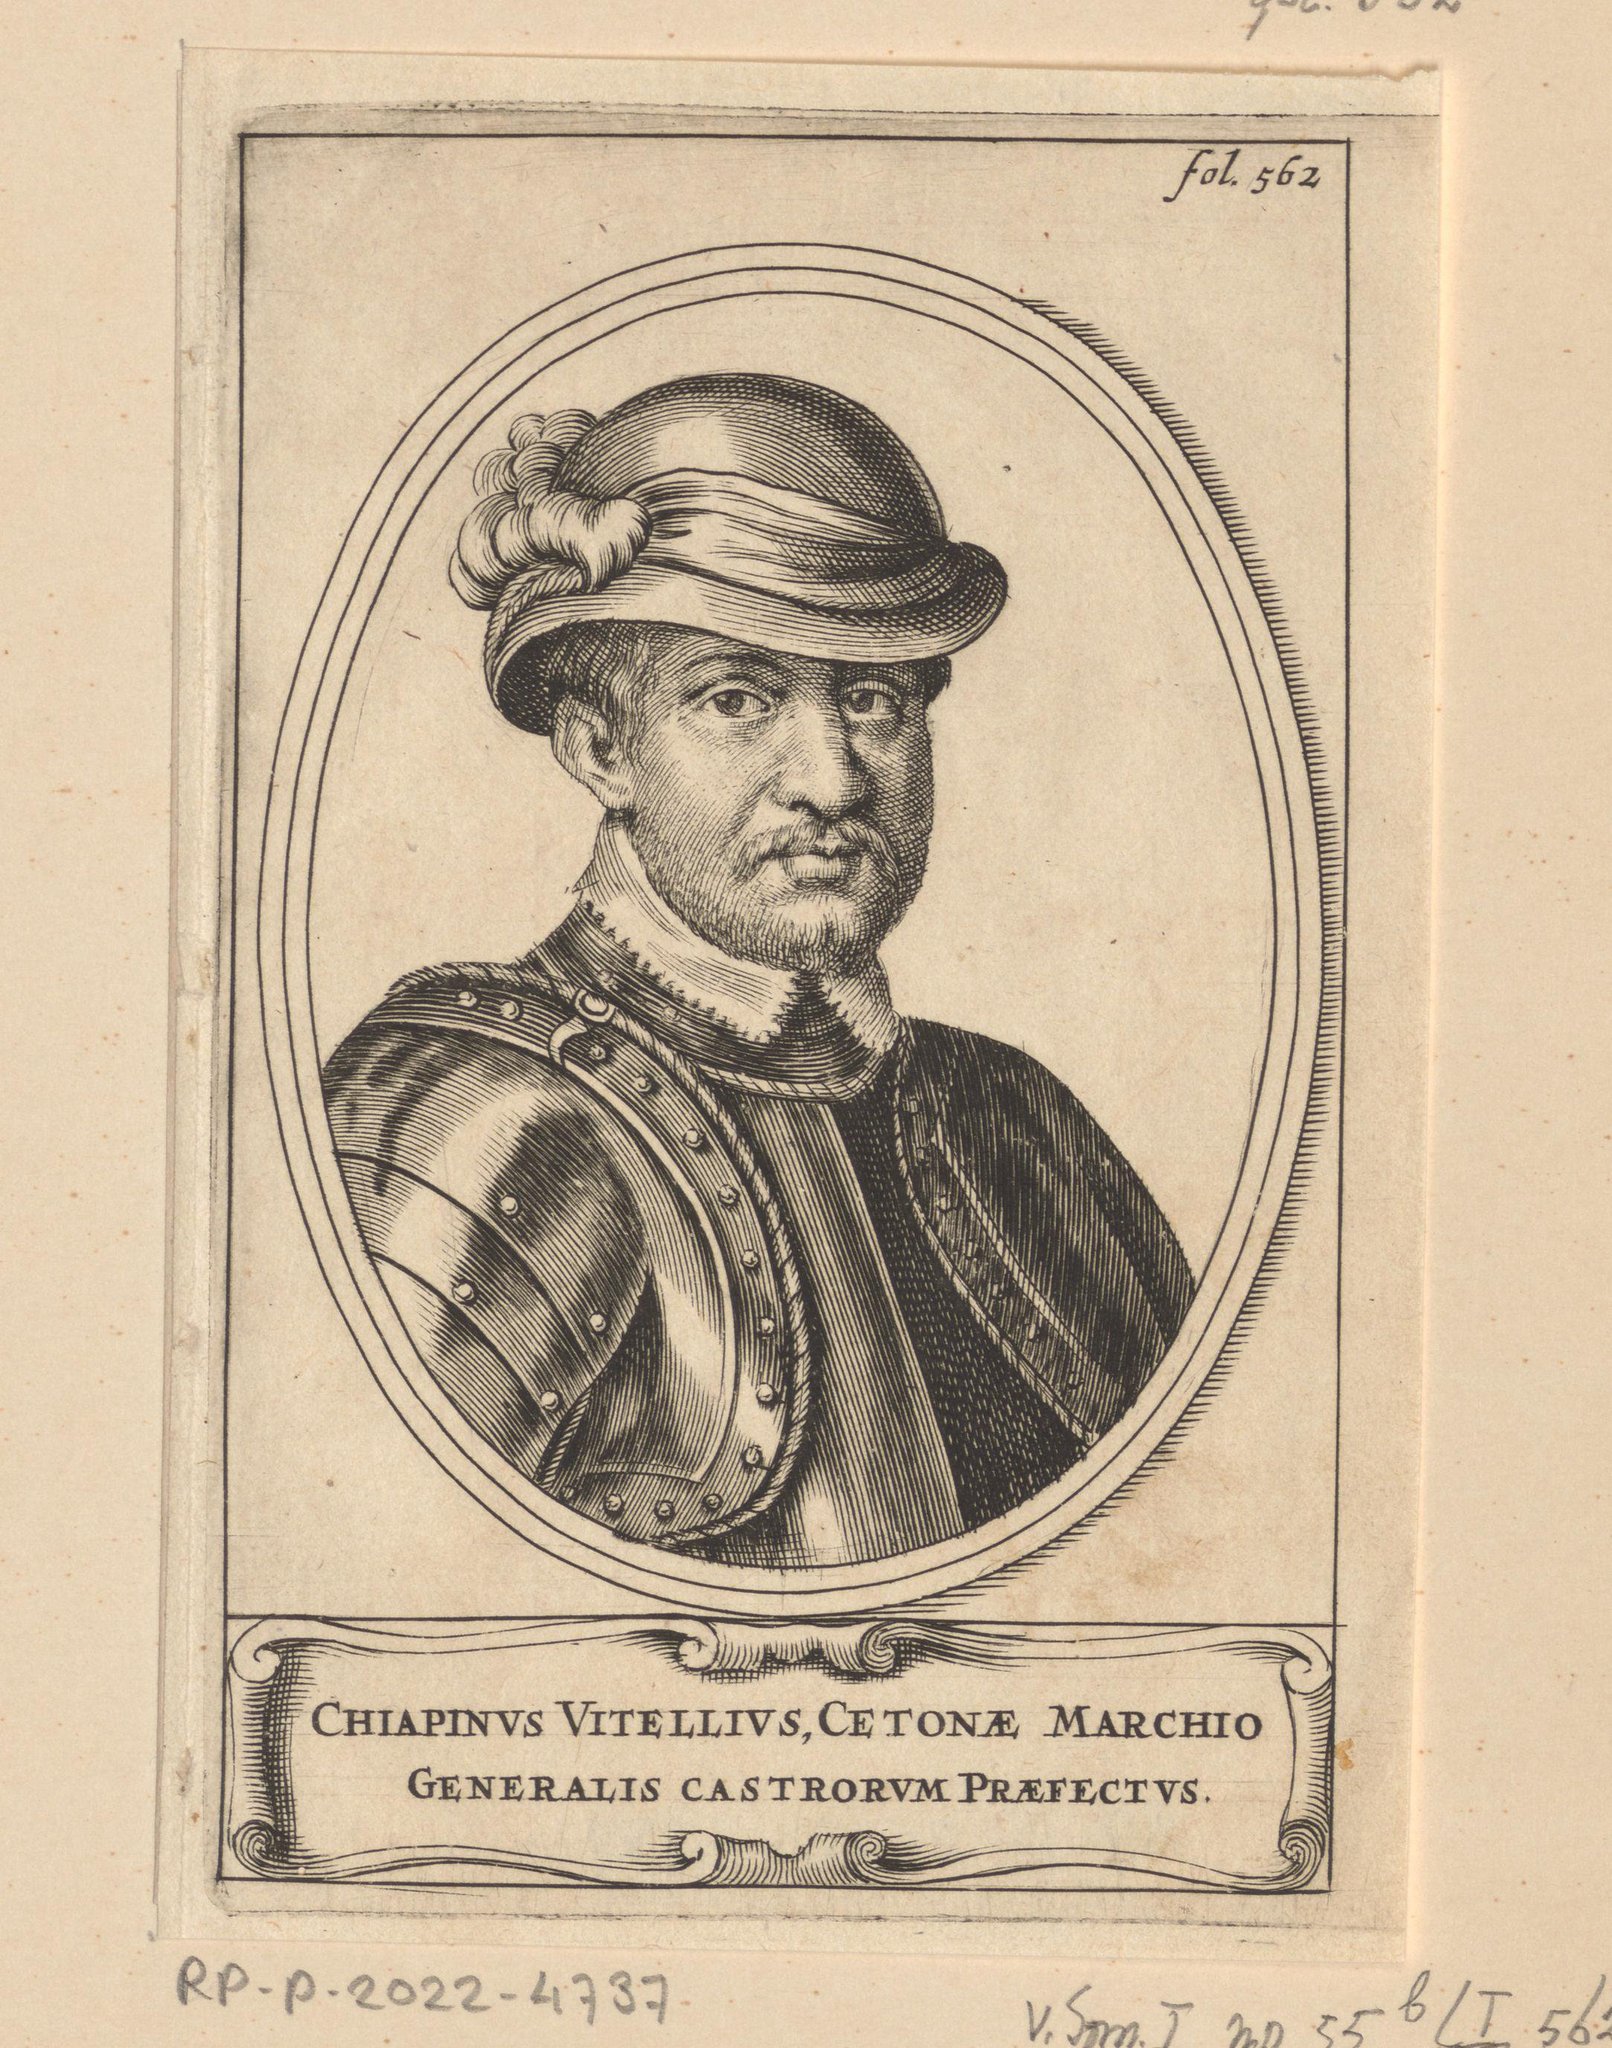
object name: print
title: Portret van Giovan Luigi Vitelli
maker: Anonymous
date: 1646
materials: paper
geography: northern netherlands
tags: commander-in-chief, general, marshal, historical persons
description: Prent waarschijnlijk uit: Strada, Famiano. De thien eerste boecken der Nederlandsche oorlogen. Amsterdam: Nicolaes van Ravesteyn, 1646. Prent ook gebruikt in de editie uit 1666.